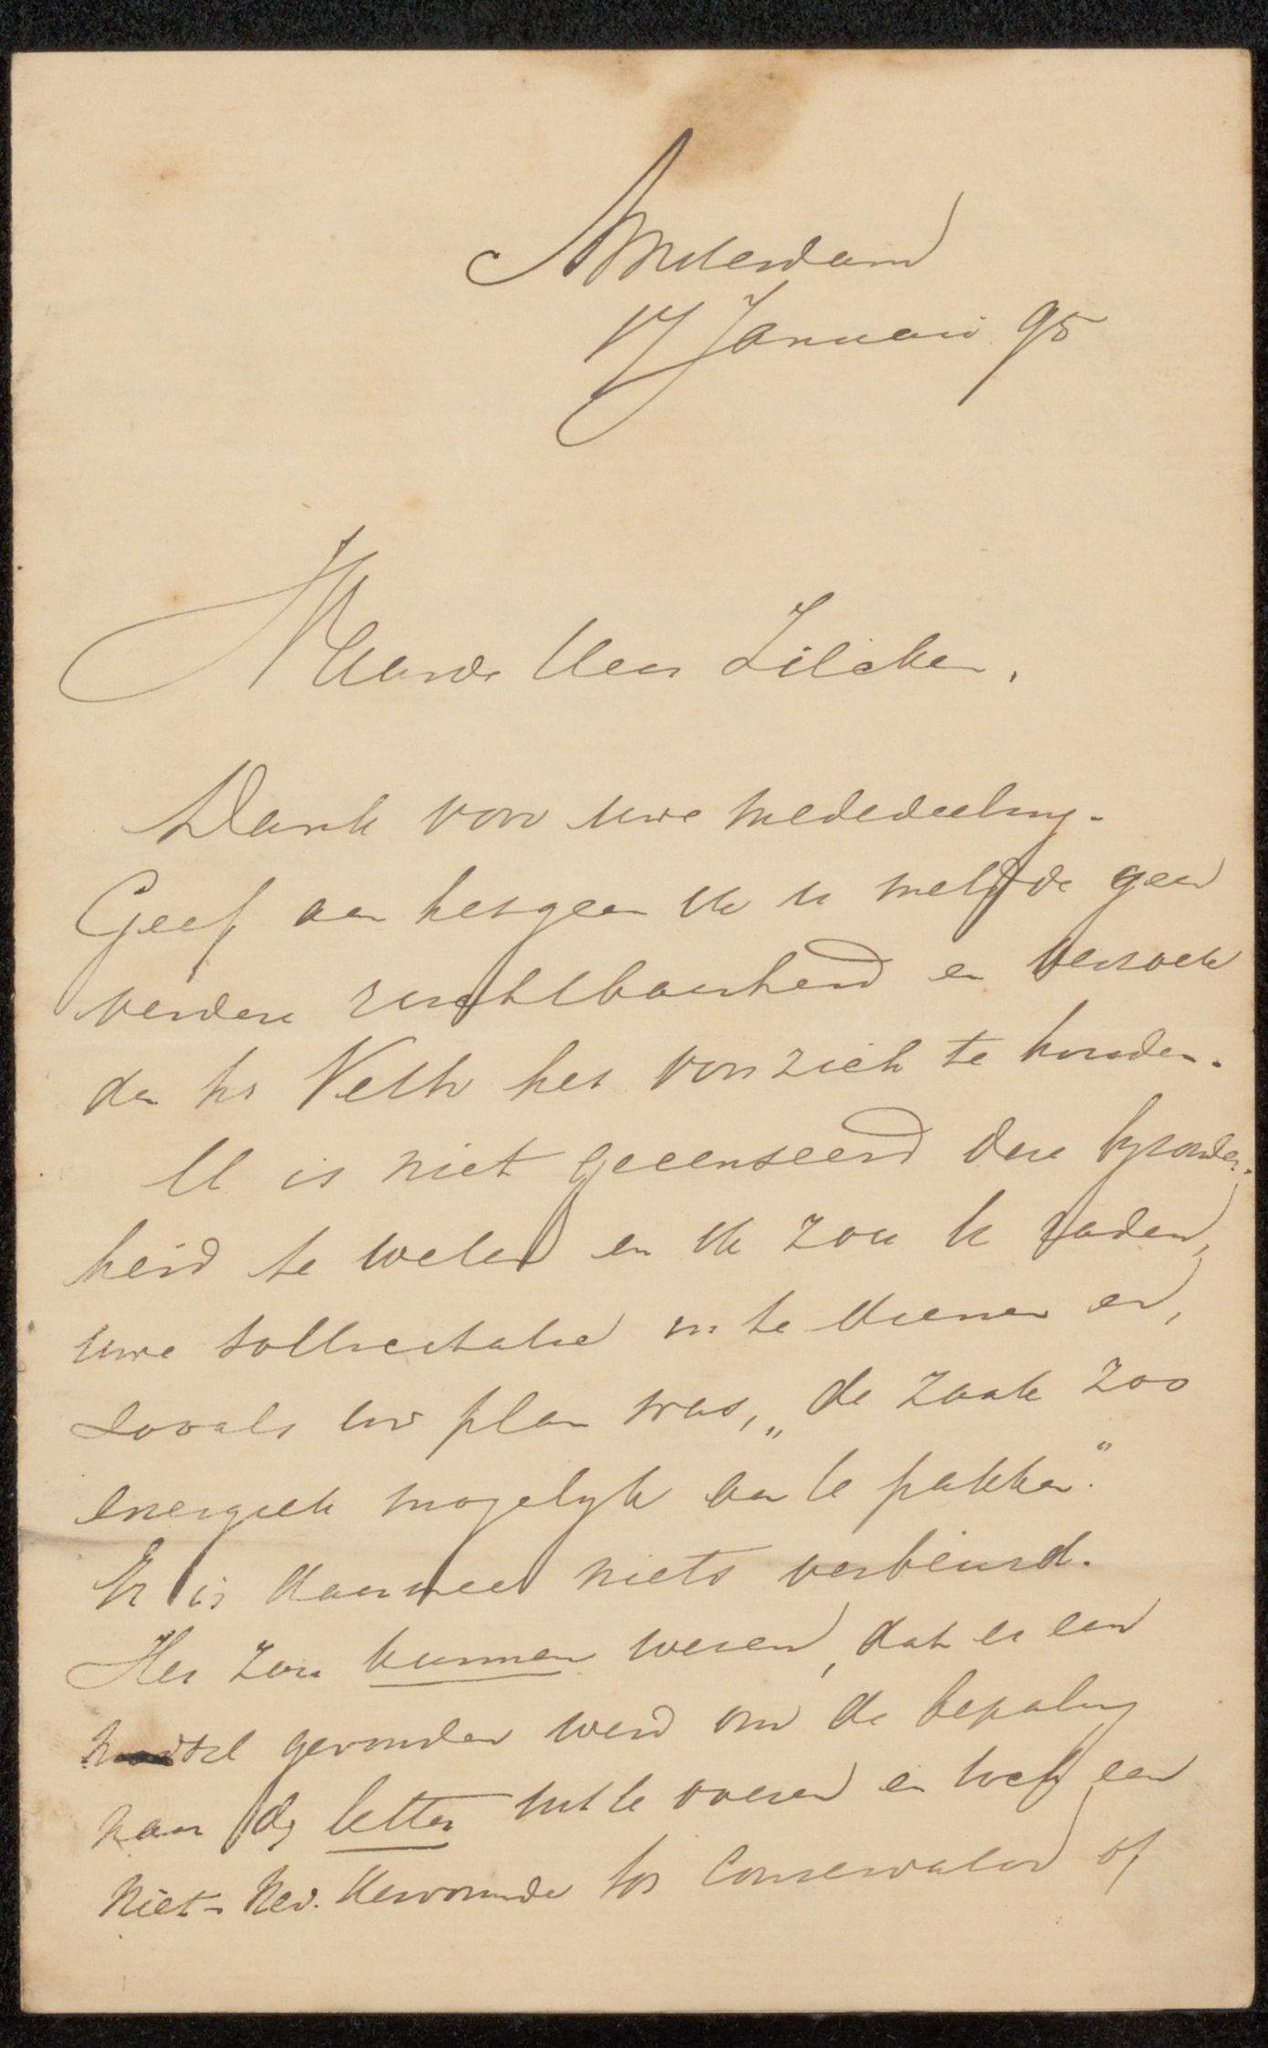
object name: letter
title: Brief aan Philip Zilcken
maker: jacob nicolaas van hall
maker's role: politician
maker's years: 1840-1918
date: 1895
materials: ink, paper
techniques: pen, writing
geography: amsterdam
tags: dordrecht, amsterdam, painter, print maker, draughtsman, designer, jan veth, the hague, philip zilcken, christian religion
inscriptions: collector's mark: ‘RPK’